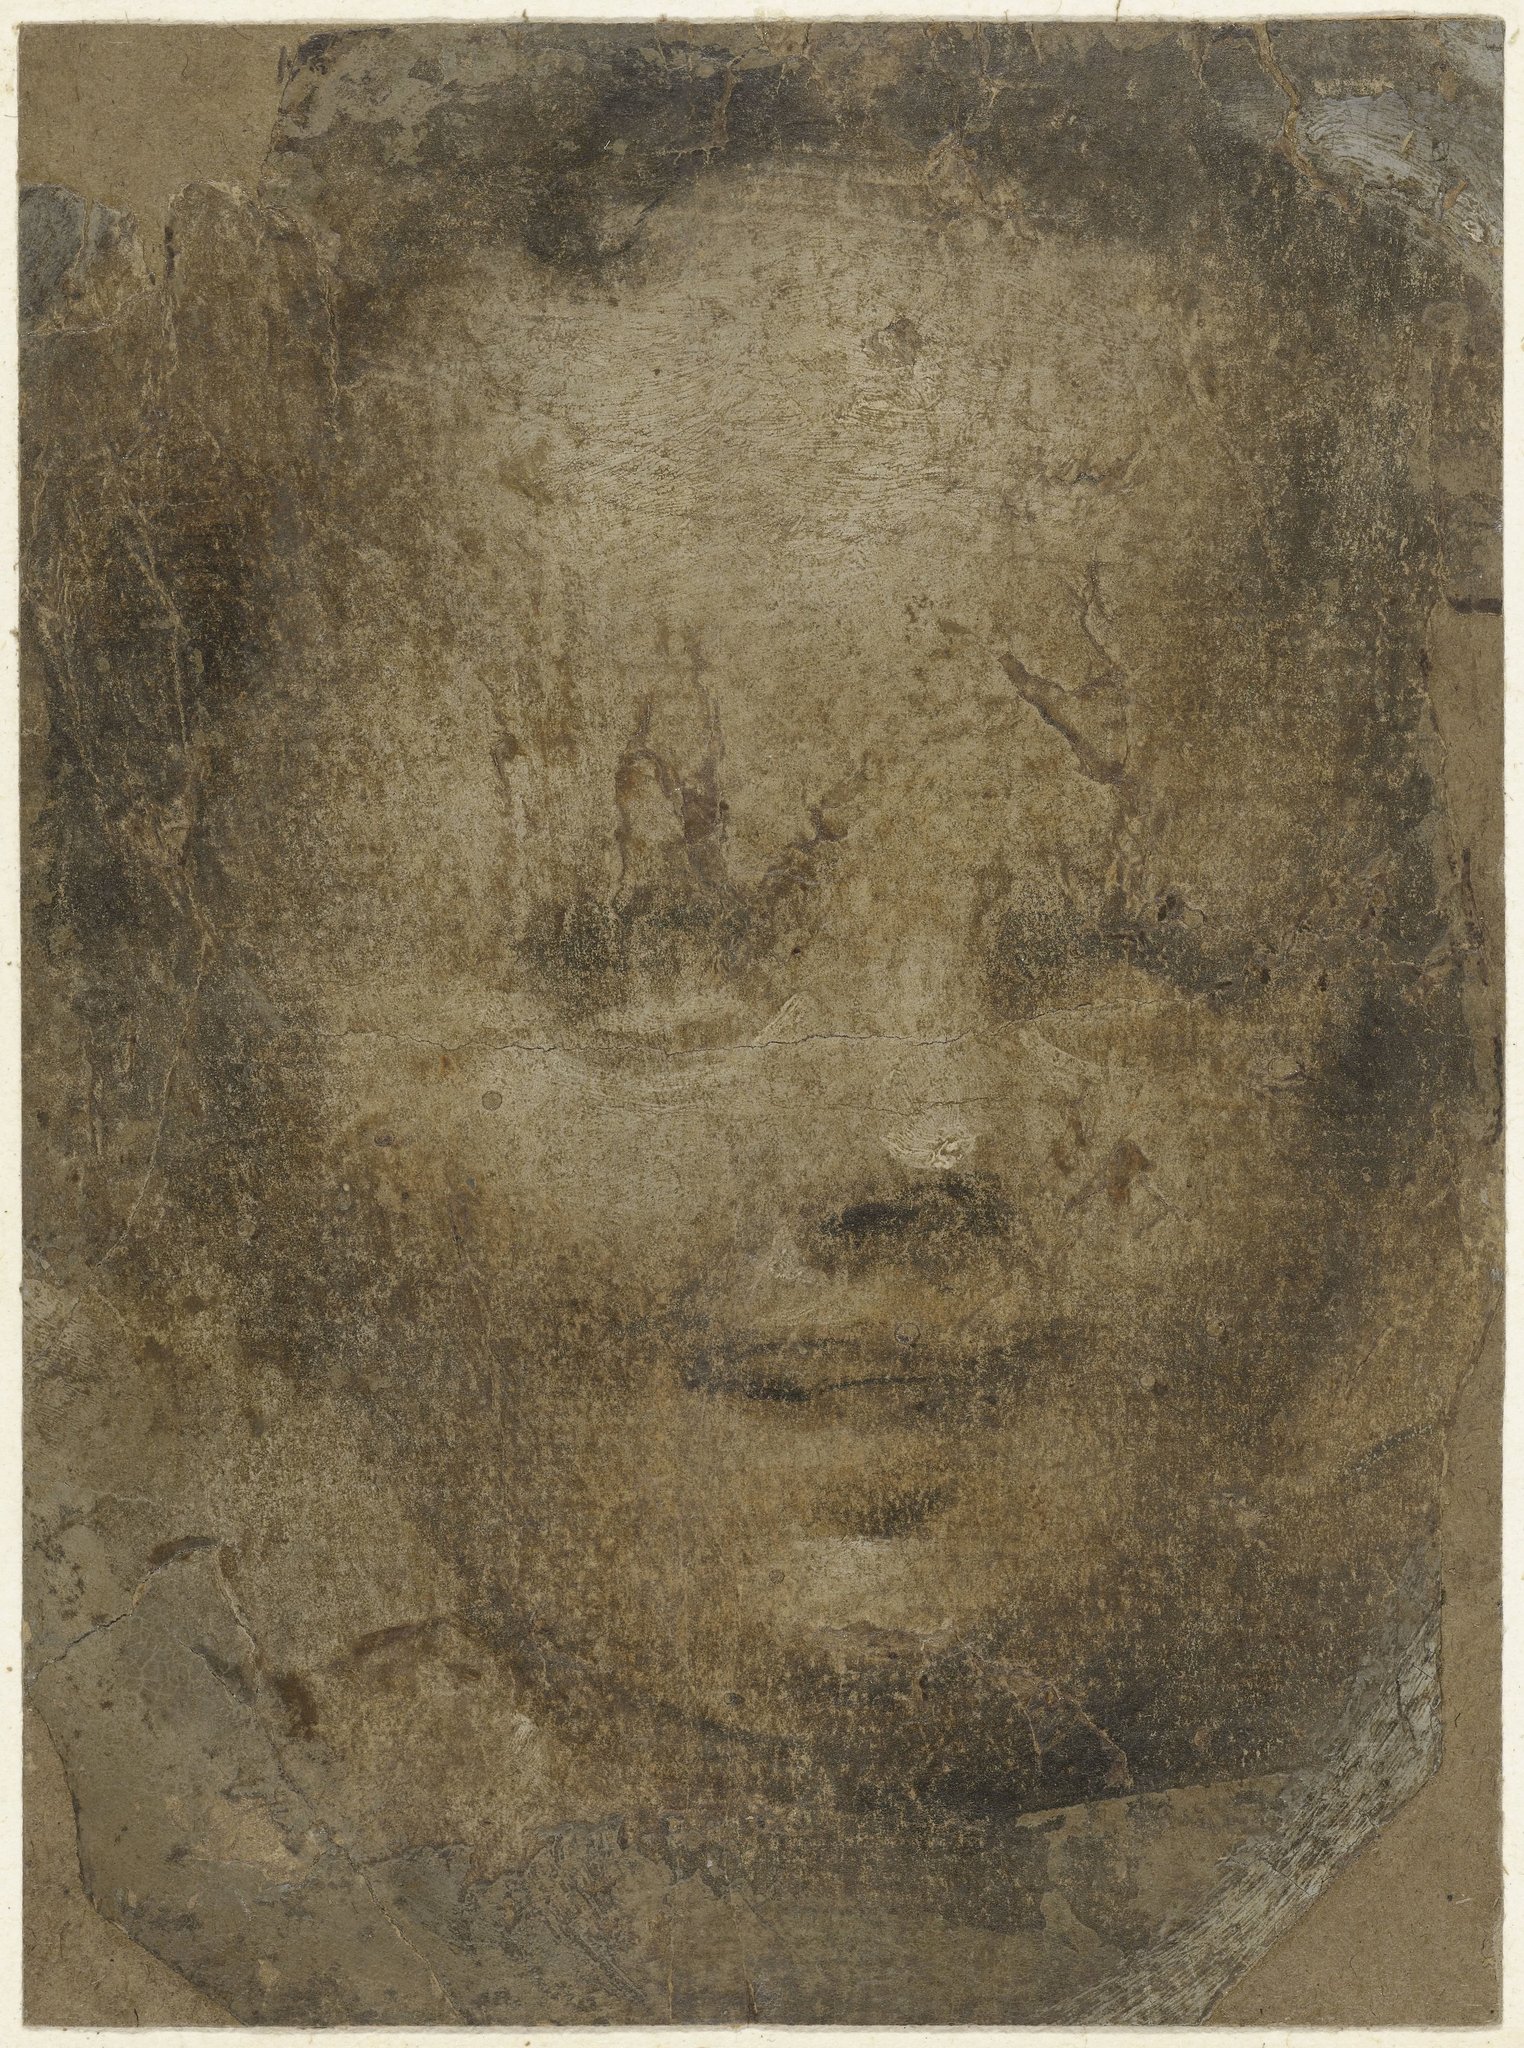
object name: drawing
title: Kinderkopje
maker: domenico beccafumi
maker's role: draughtsman, painter, print maker, sculptor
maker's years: 1486-1551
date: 1529-1535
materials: cardboard, paint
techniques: varnishing